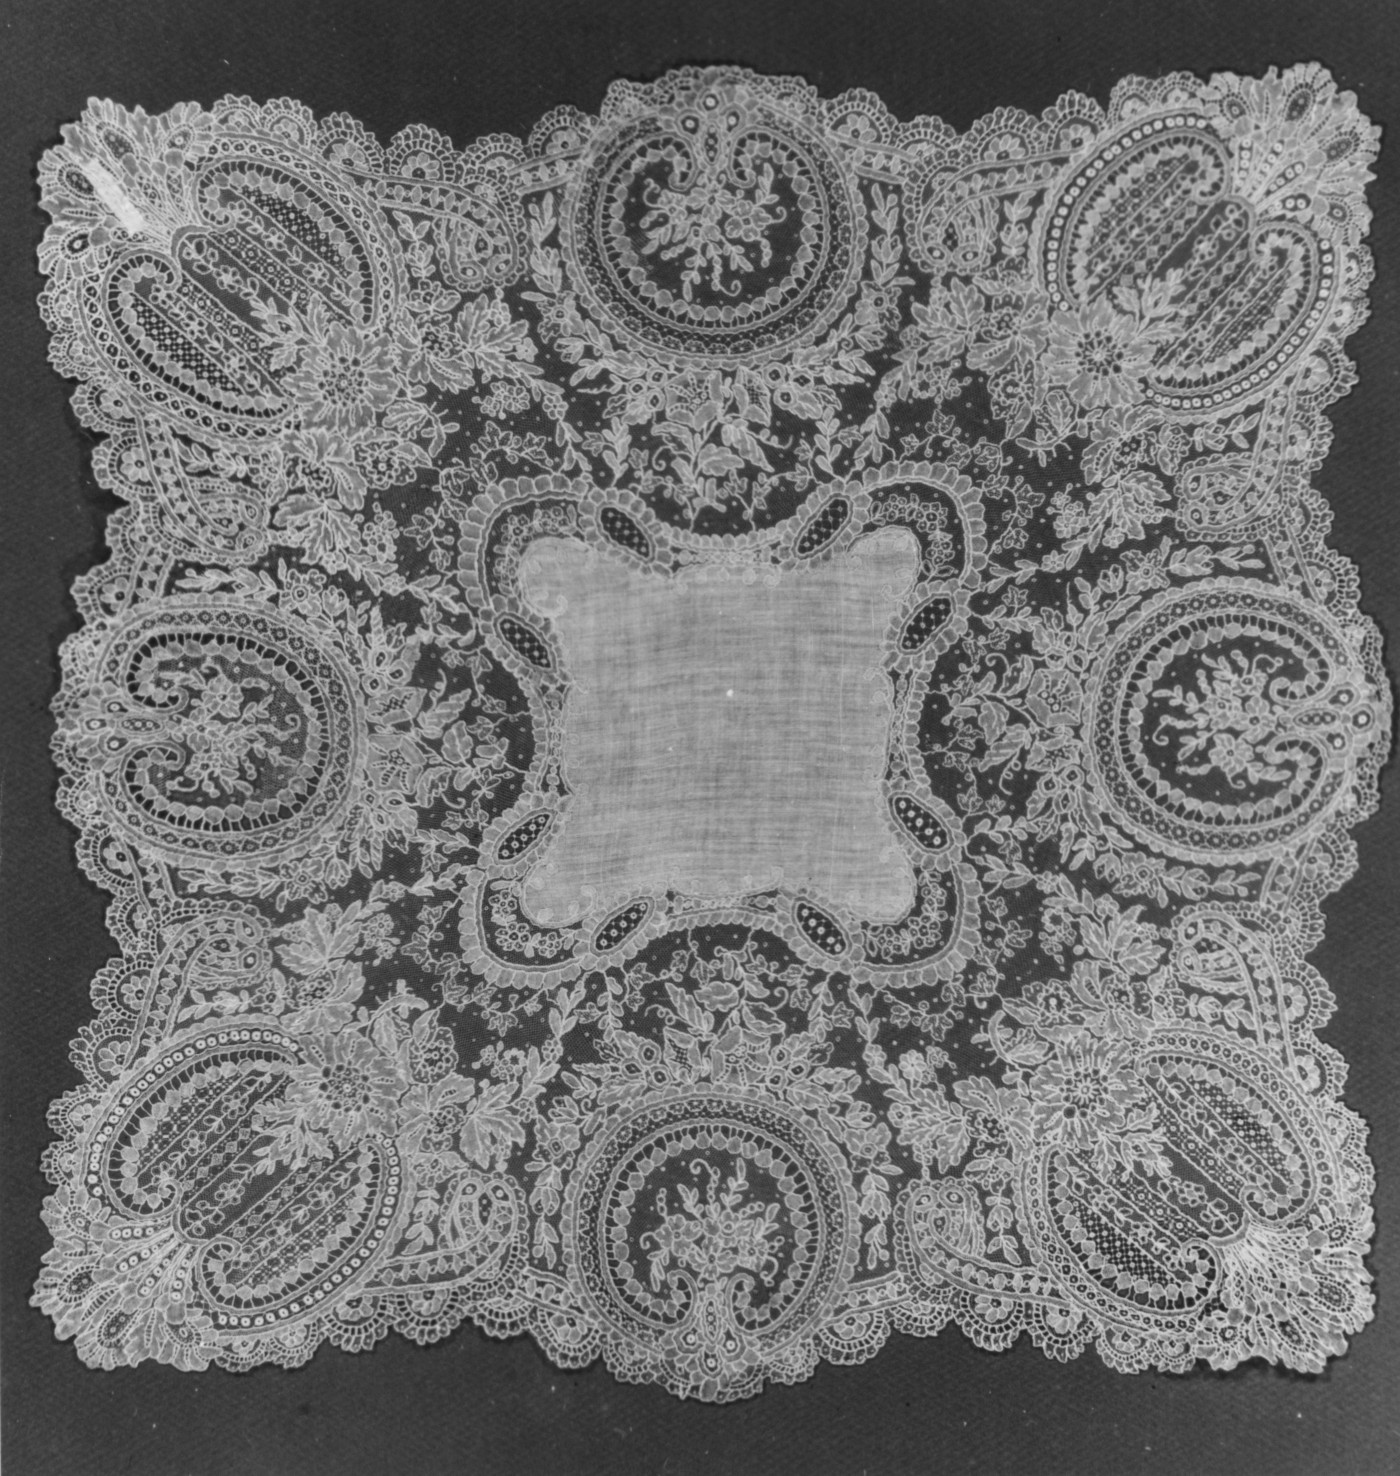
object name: handkerchief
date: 1801-1900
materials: linen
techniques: lace